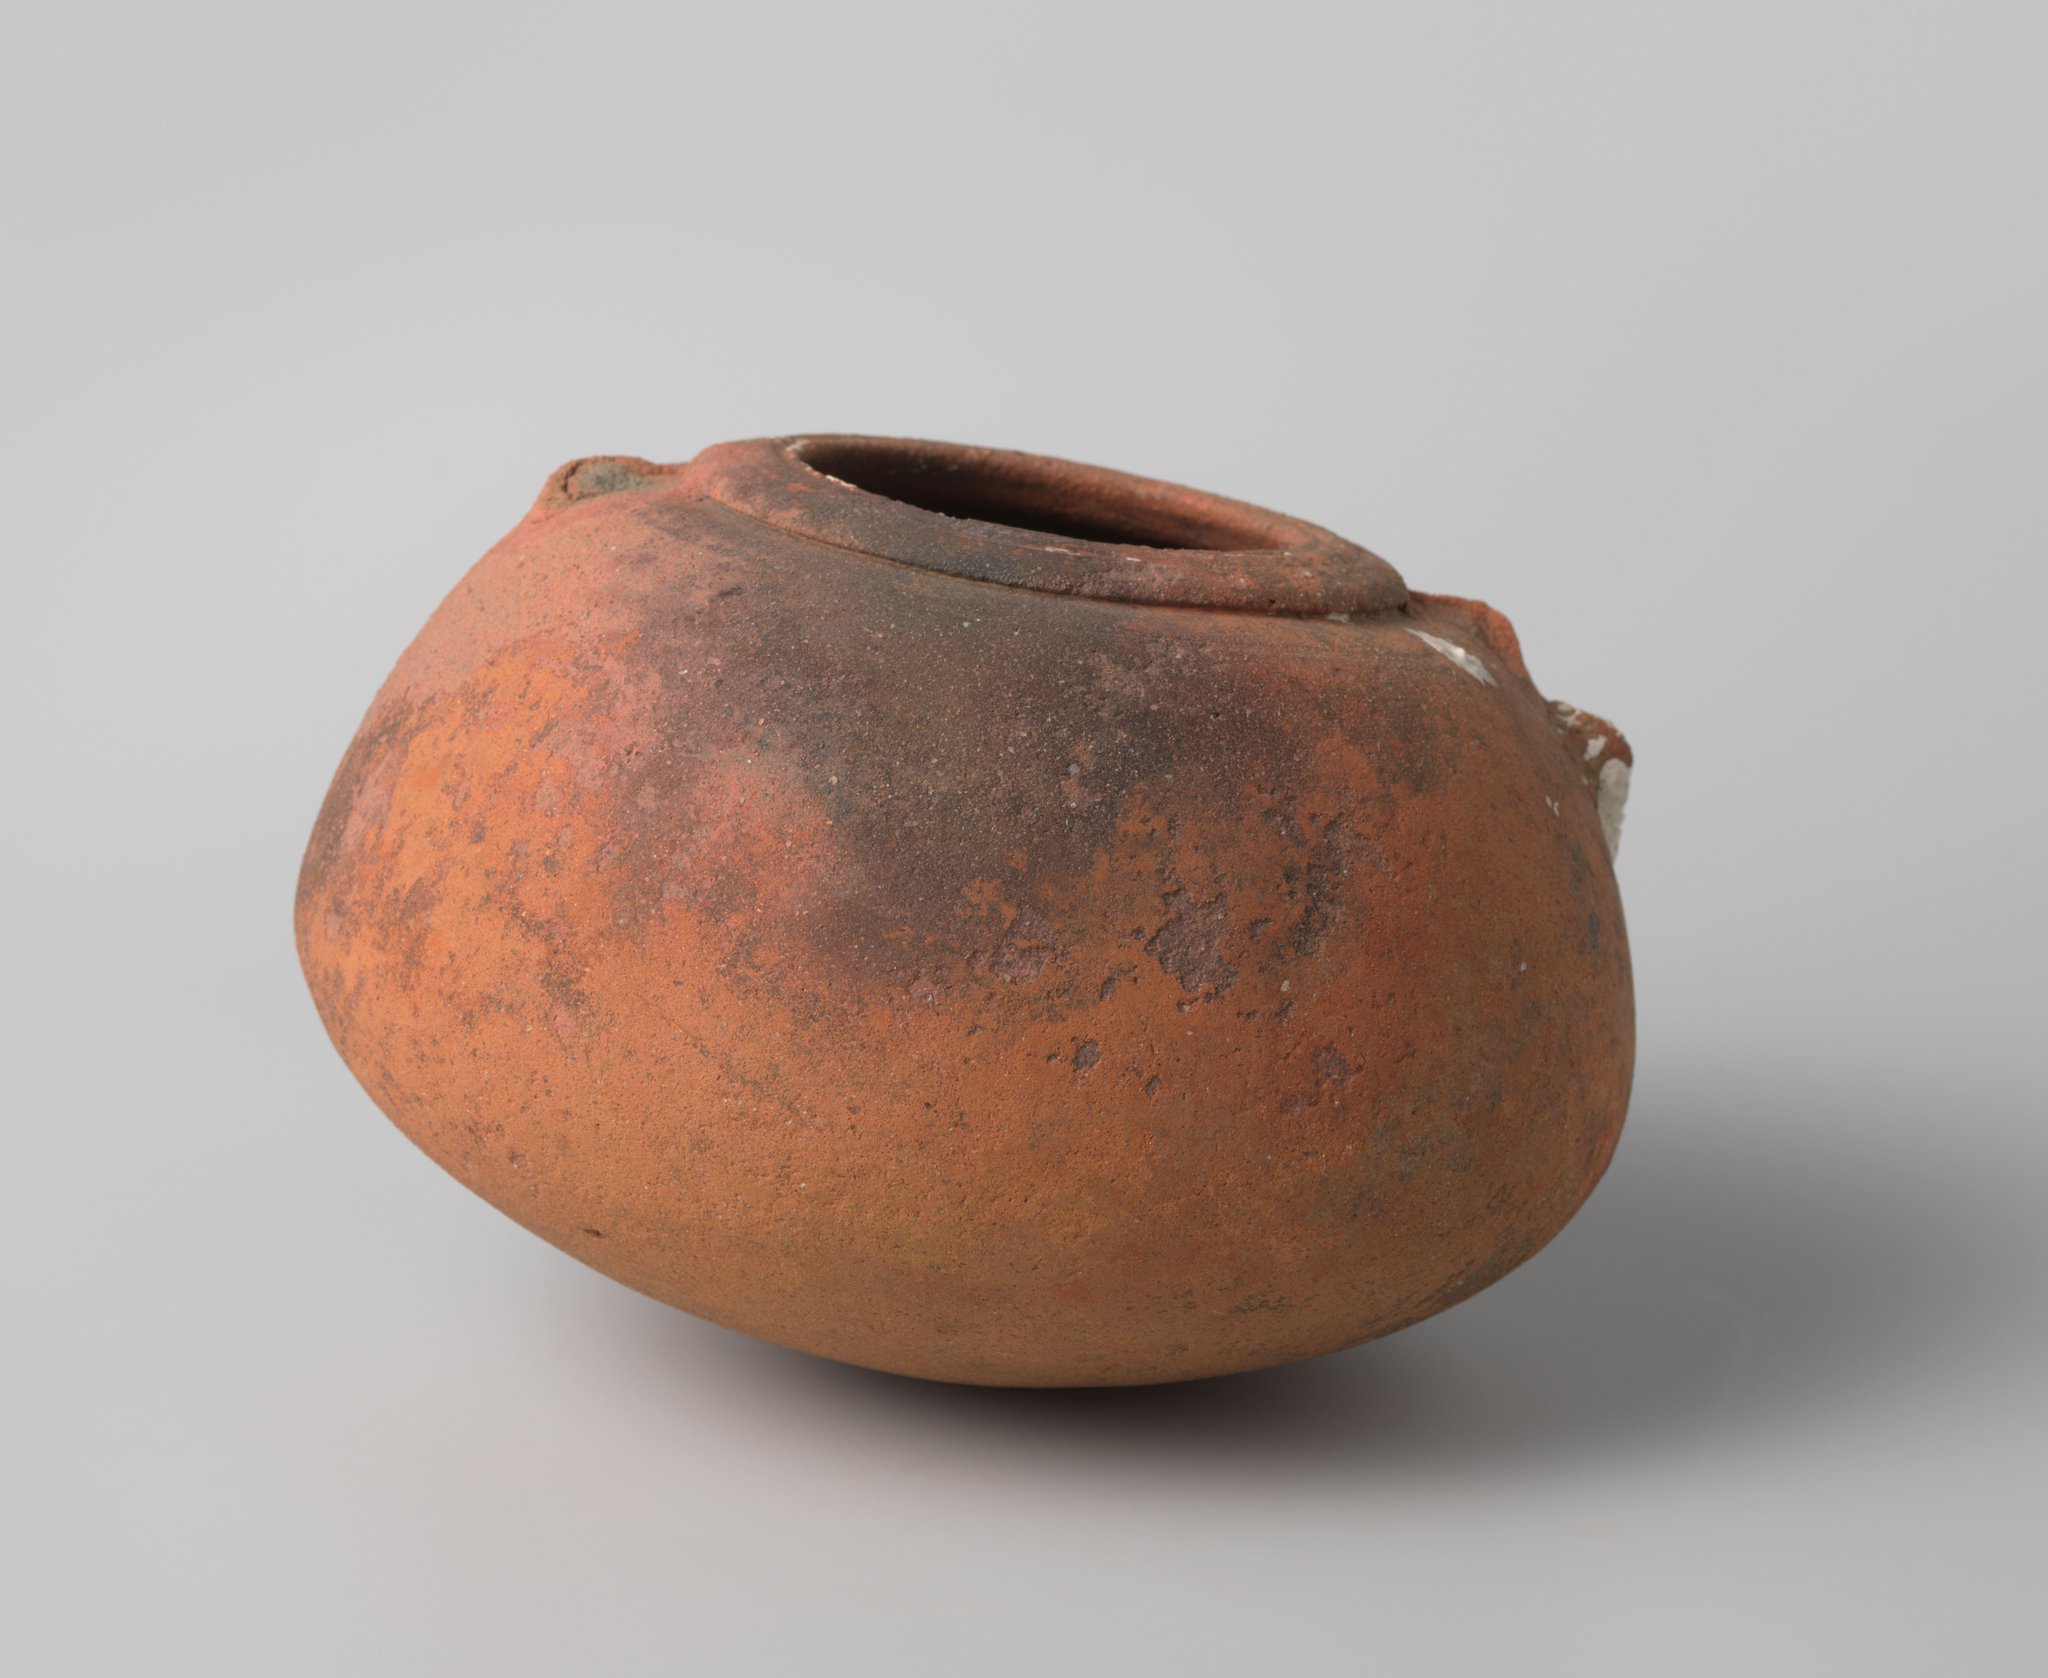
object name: pot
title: Pot uit V.O.C.-schip de 'Witte Leeuw'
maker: Anonymous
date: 1613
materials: earthenware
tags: verenigde oostindische compagnie, sint-helena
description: Pot uit V.O.C.-schip de 'Witte Leeuw'. Lage pot met op de schouder sporen van handvaten of oren. Op de zijkanten zitten zwarte plekken die mogelijk zijn veroorzaakt doordat de pot werd gebruikt om te koken.